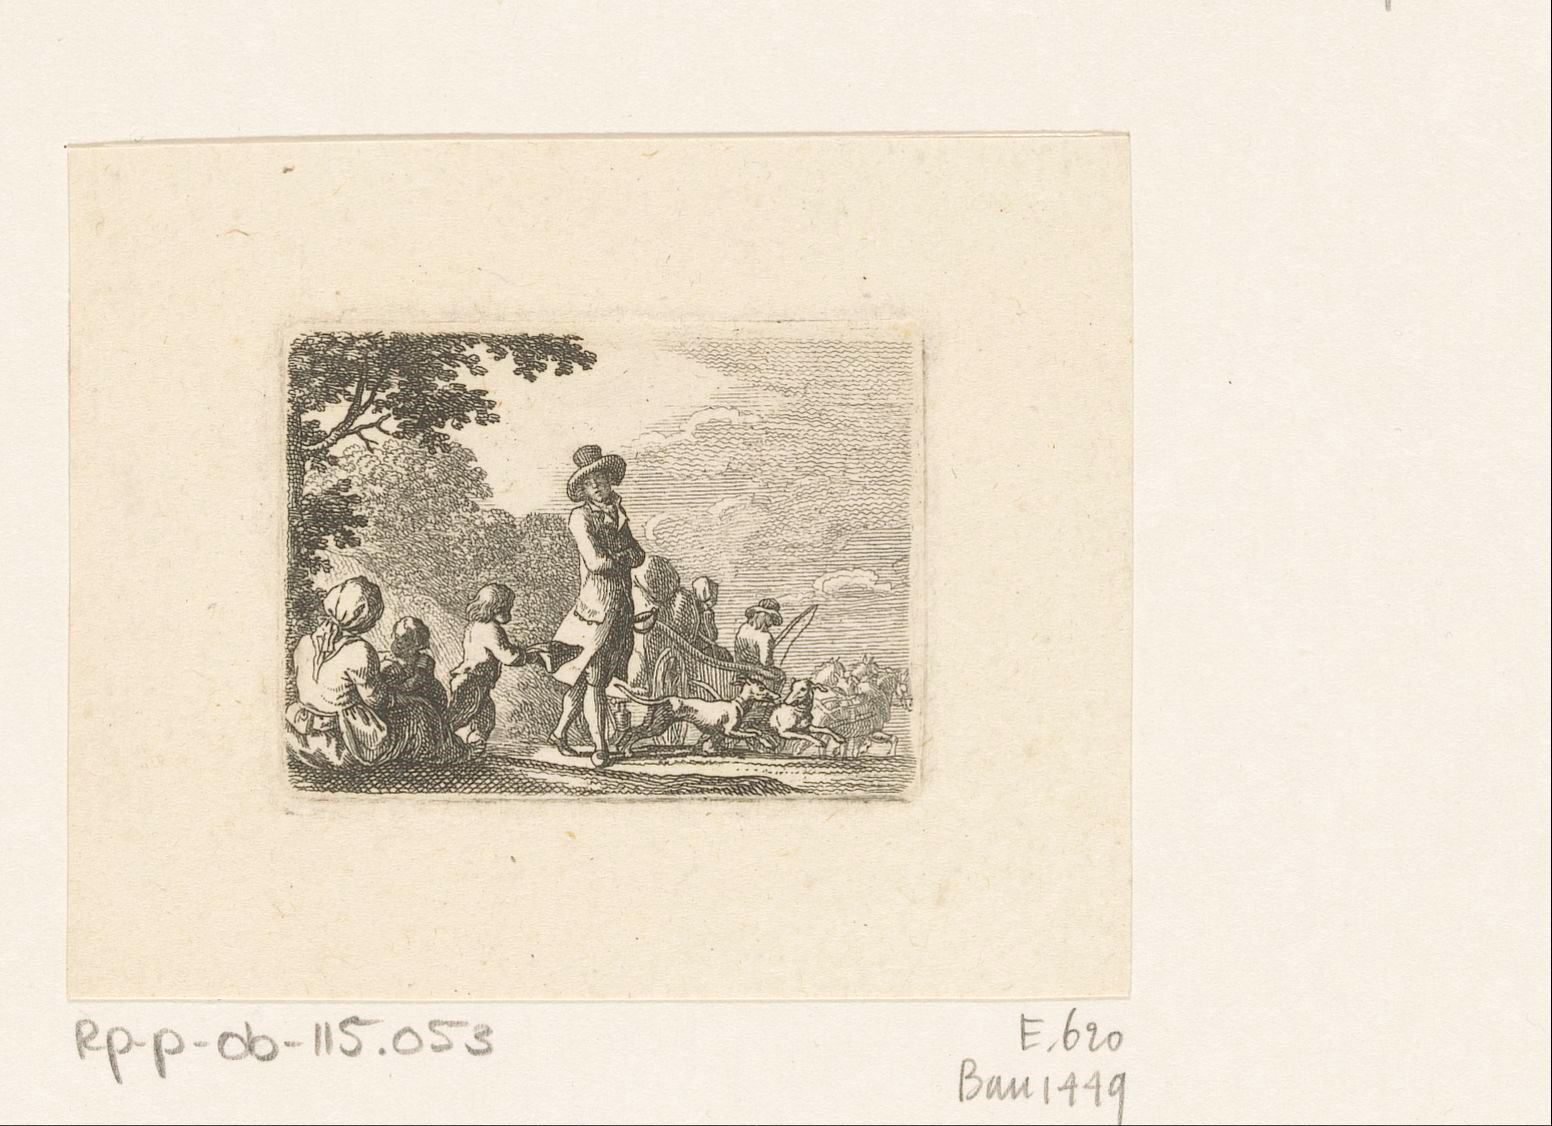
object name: print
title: Landschap met reizigers en bedelaars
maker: daniel nikolaus chodowiecki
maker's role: draughtsman, print maker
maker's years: 1726-1801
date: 1789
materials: paper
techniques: etching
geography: berlin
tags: landscapes, 'en route', traveller under way, beggar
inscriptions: collector's mark: Lugt 2228